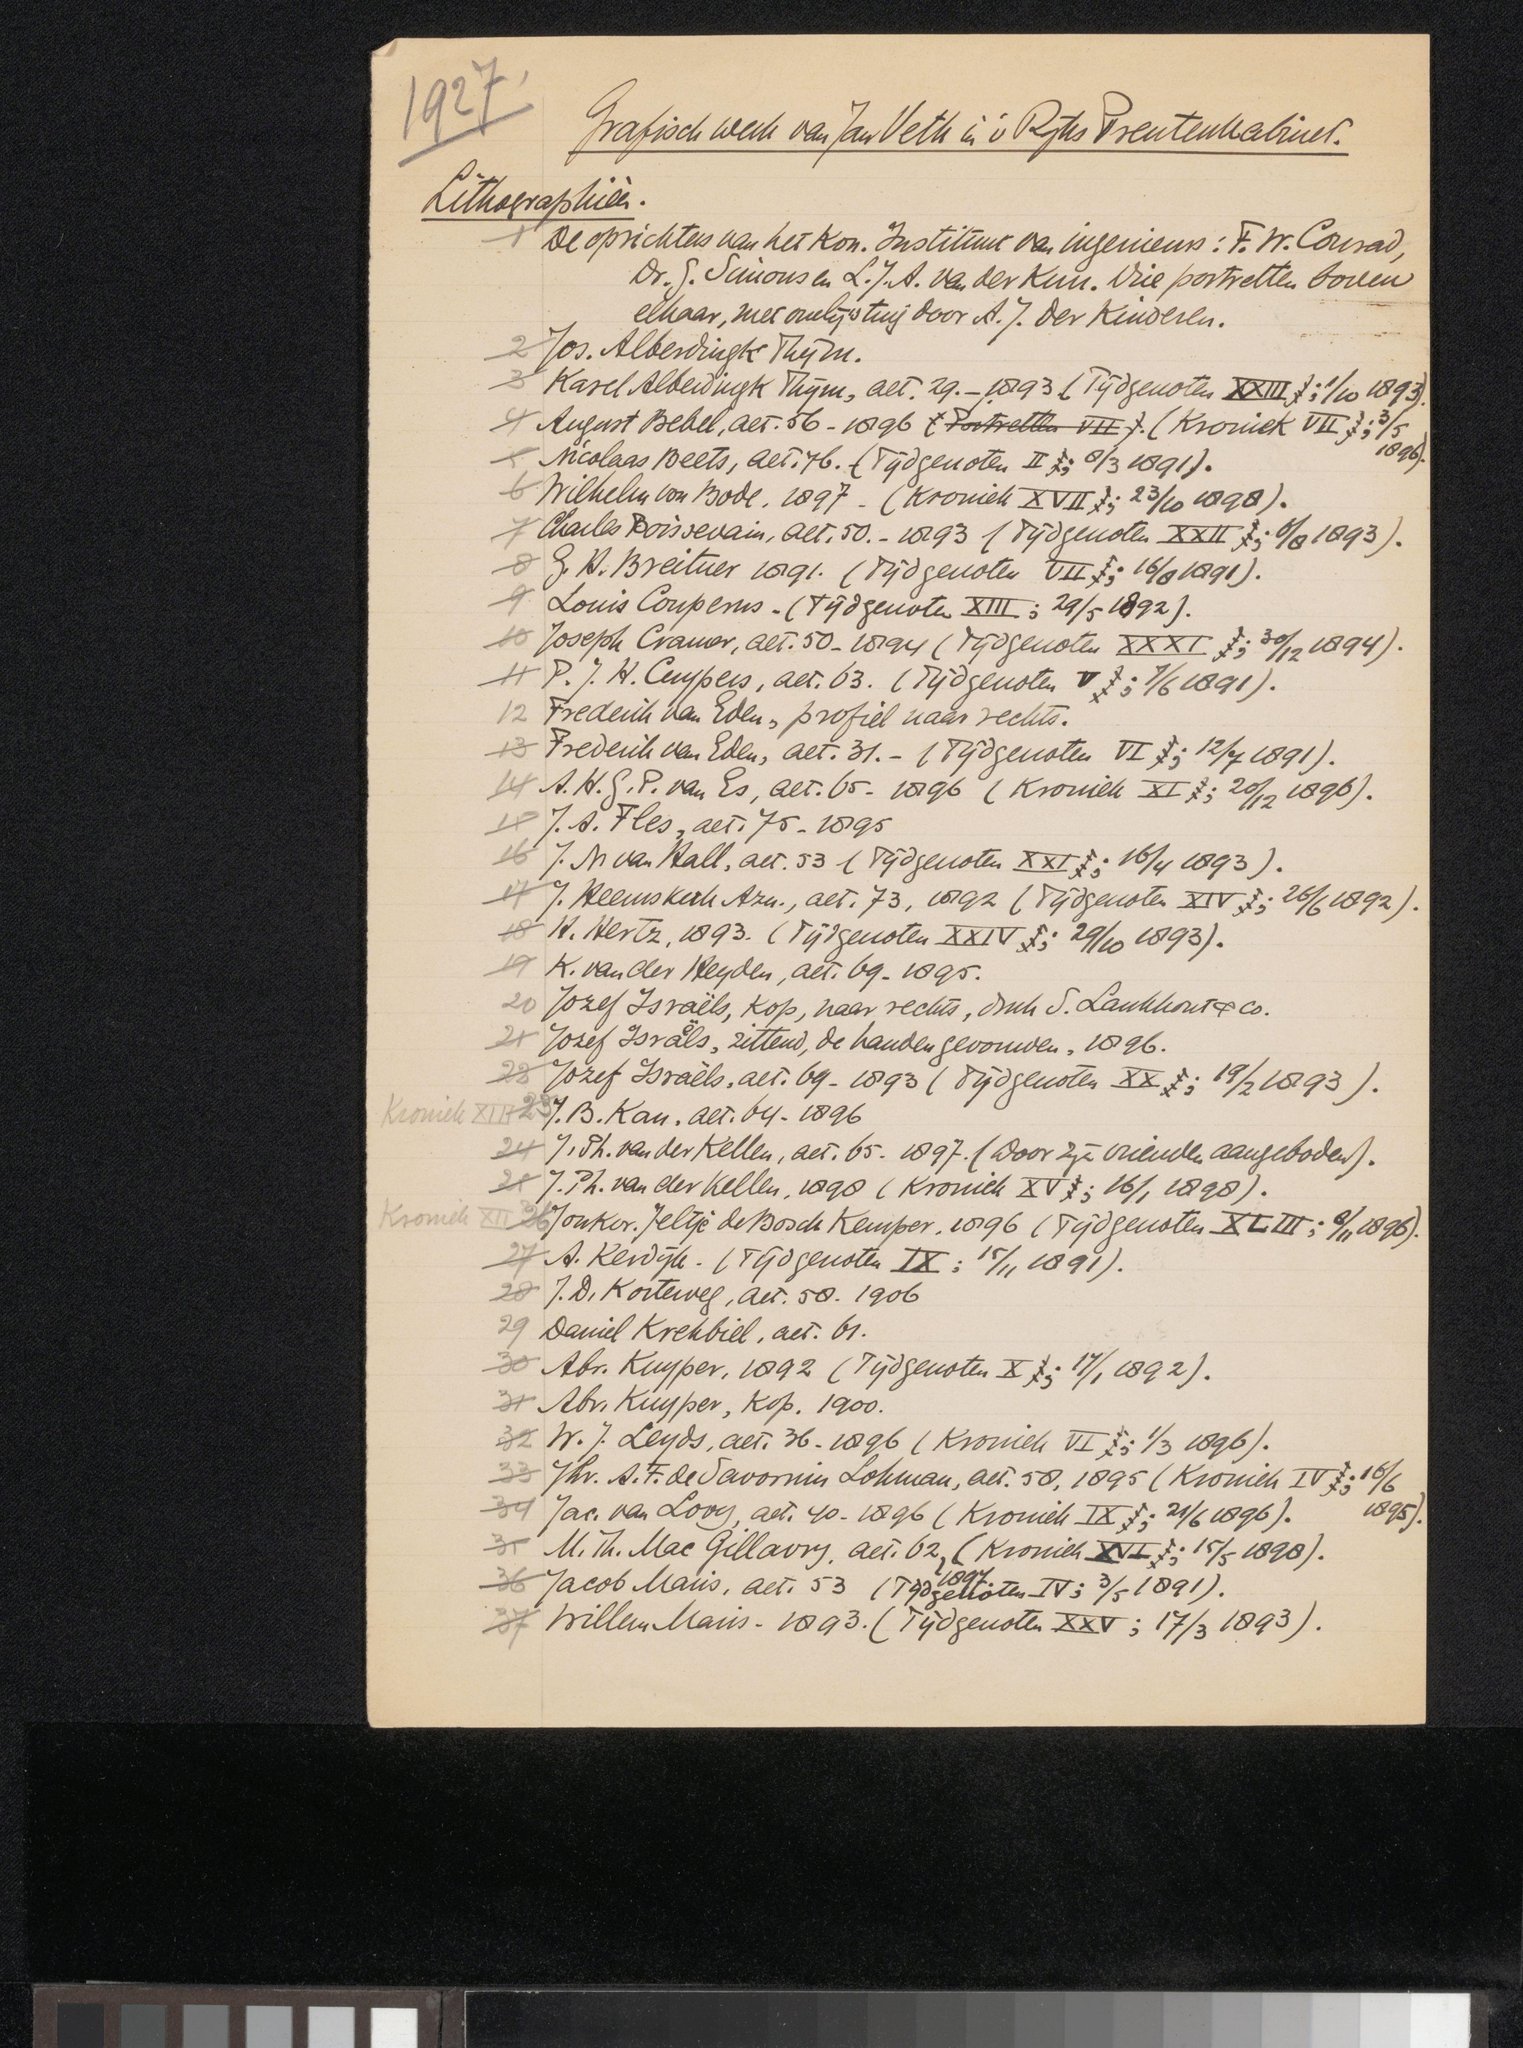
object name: manuscript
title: Lijst en aantekeningen van het grafisch werk van Jan Veth in het Rijksprentenkabinet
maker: Anonymous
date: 1927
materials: ink, paper, pencil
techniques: pen, writing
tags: print room, dordrecht, painter, print maker, draughtsman, designer, jan veth, the graphic arts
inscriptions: collector's mark: Lugt 2233